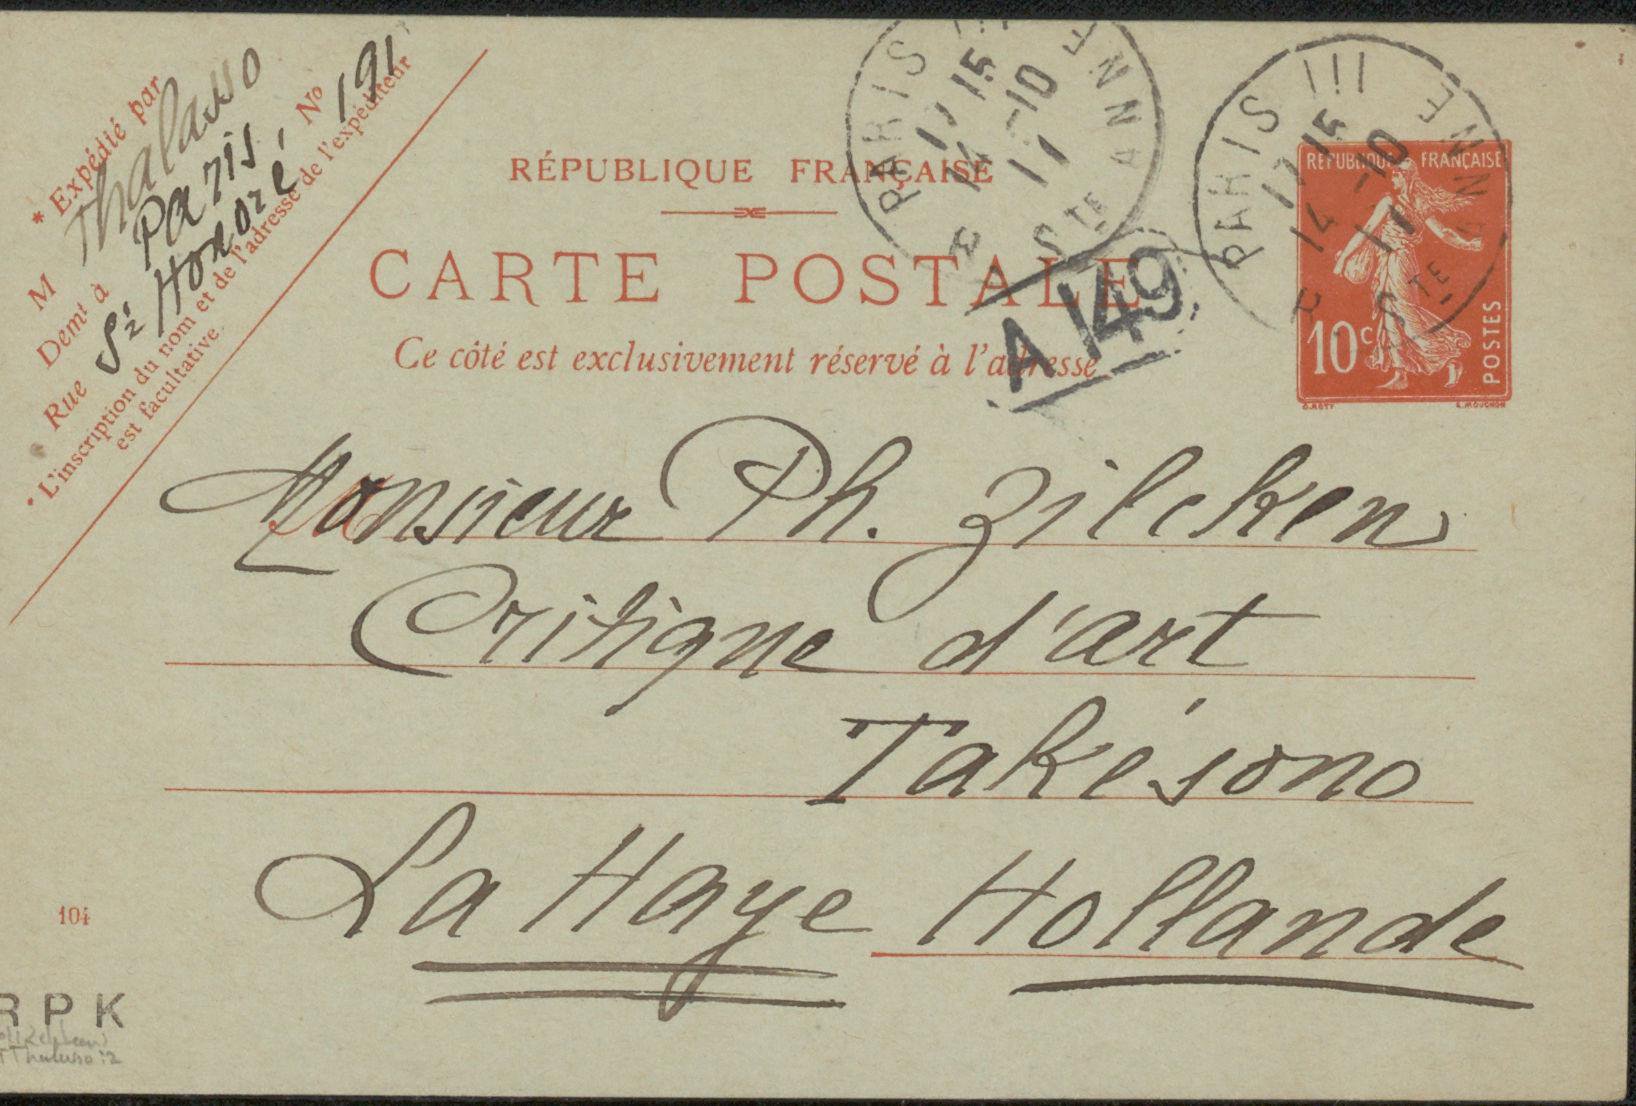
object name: postcard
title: Briefkaart aan Philip Zilcken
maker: adolphe thalasso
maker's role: criticus, dichter, dramaturg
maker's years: 1858-1919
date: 1911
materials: cardboard, ink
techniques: pen, writing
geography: paris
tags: the hague, painter, draughtsman, philip zilcken, drawing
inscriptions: collector's mark: ‘RPK’